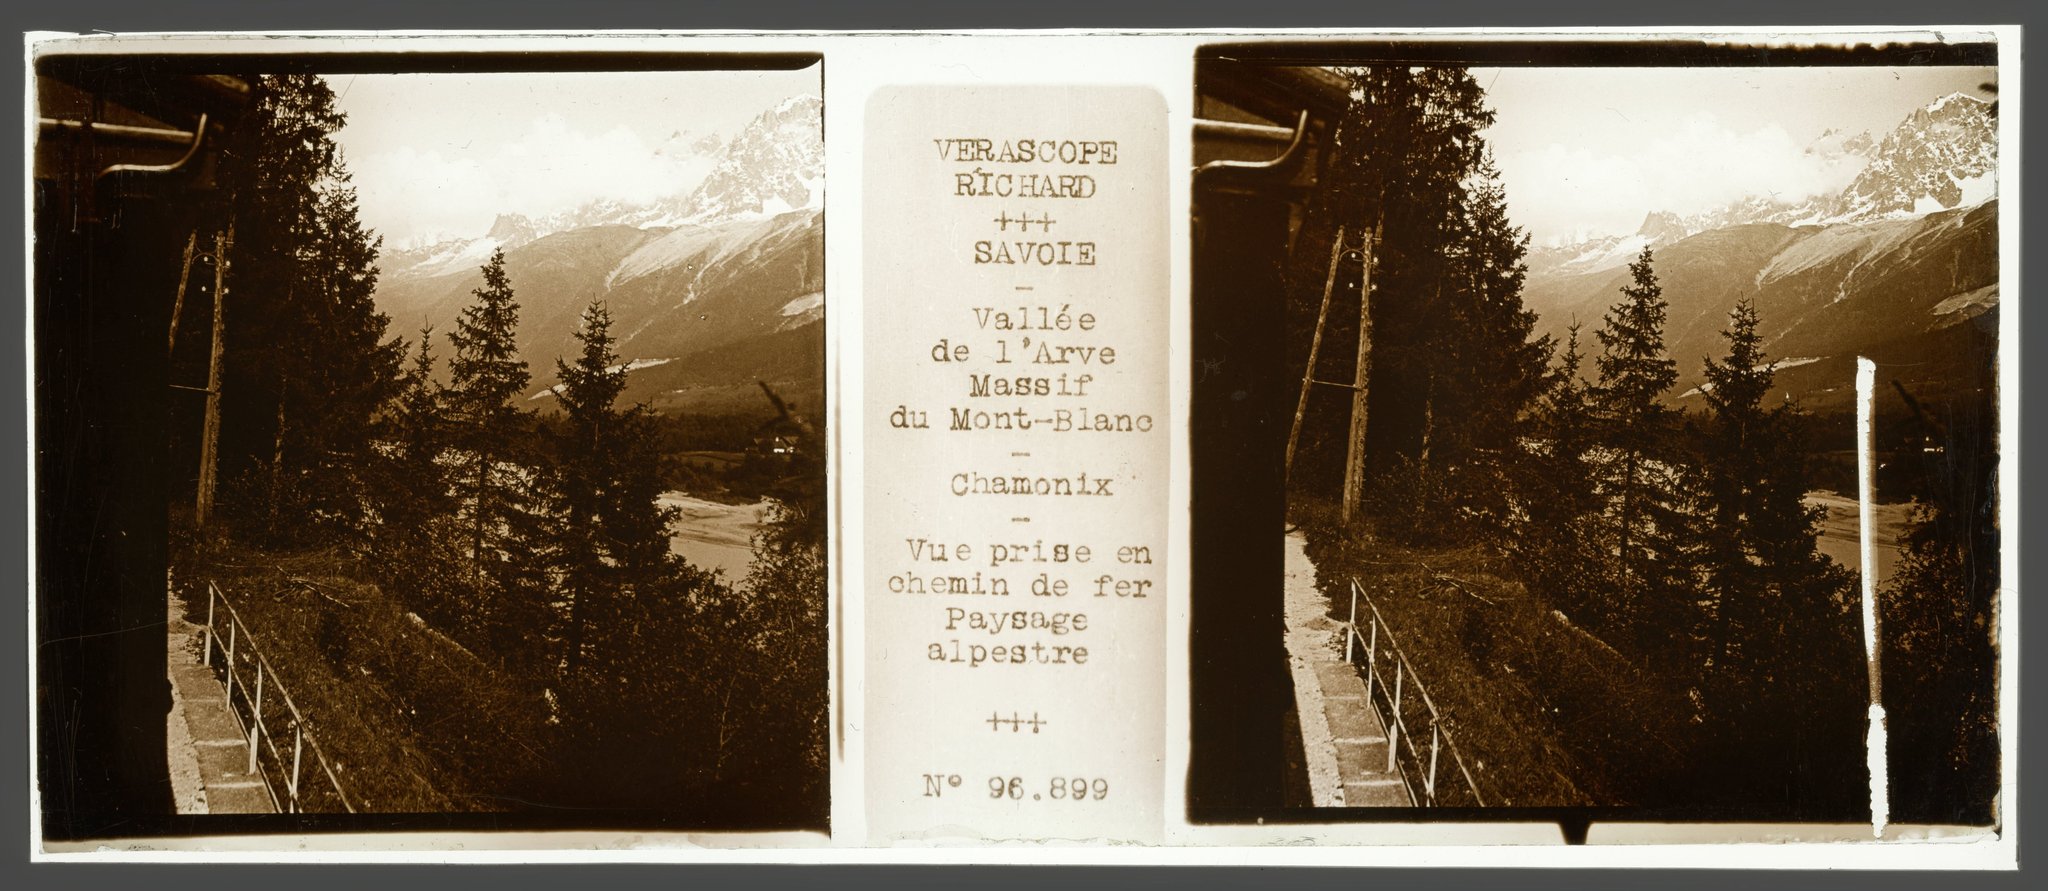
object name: stereoscopic photograph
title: Savoie - Vallee de l'Arve, Massif du Mont-Blanc - Chamonix - Vue prise en chemin de fer, Paysage alpestre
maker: Anonymous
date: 1893-1920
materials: glass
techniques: gelatin silver transparency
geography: chamonix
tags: mountains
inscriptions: number: ‘No 96.899’